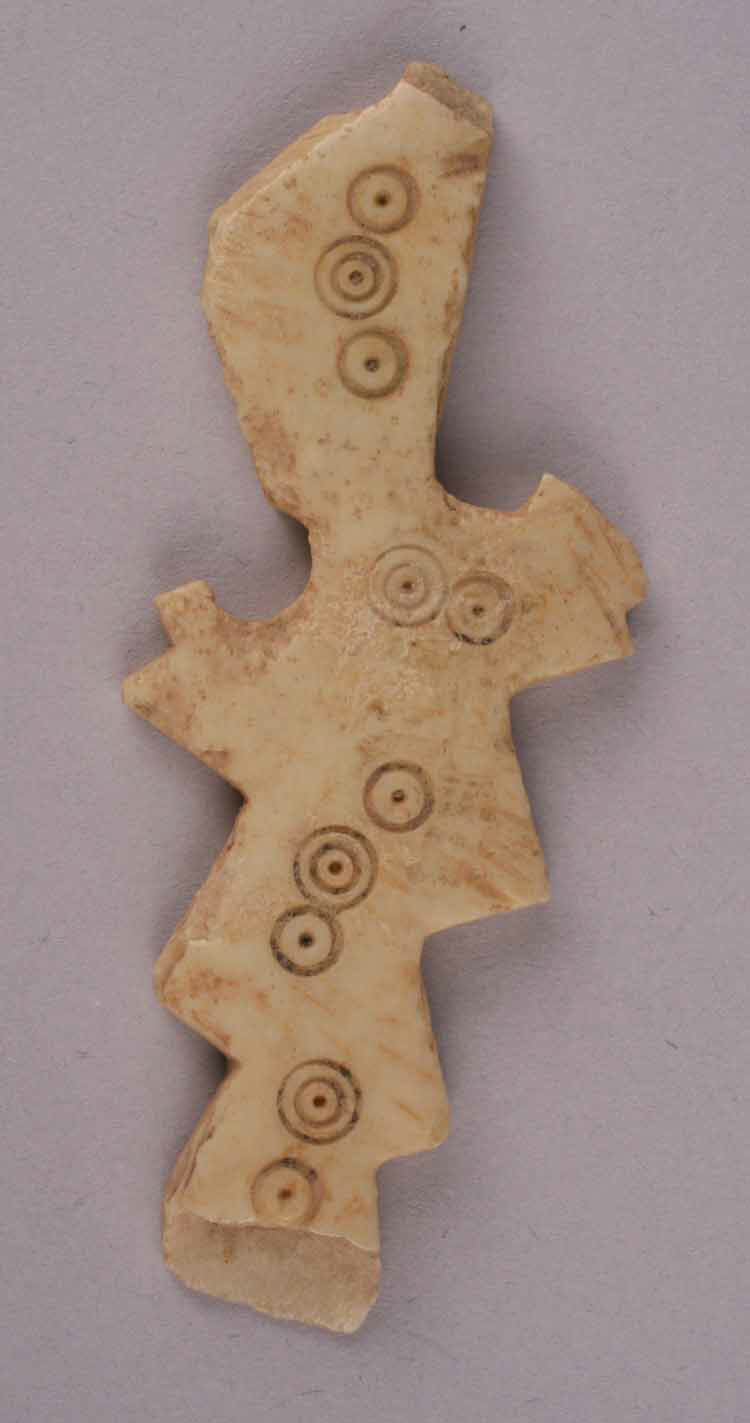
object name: handle or ornament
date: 801-1000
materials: bone, paint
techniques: carving, incising, inlay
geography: iran